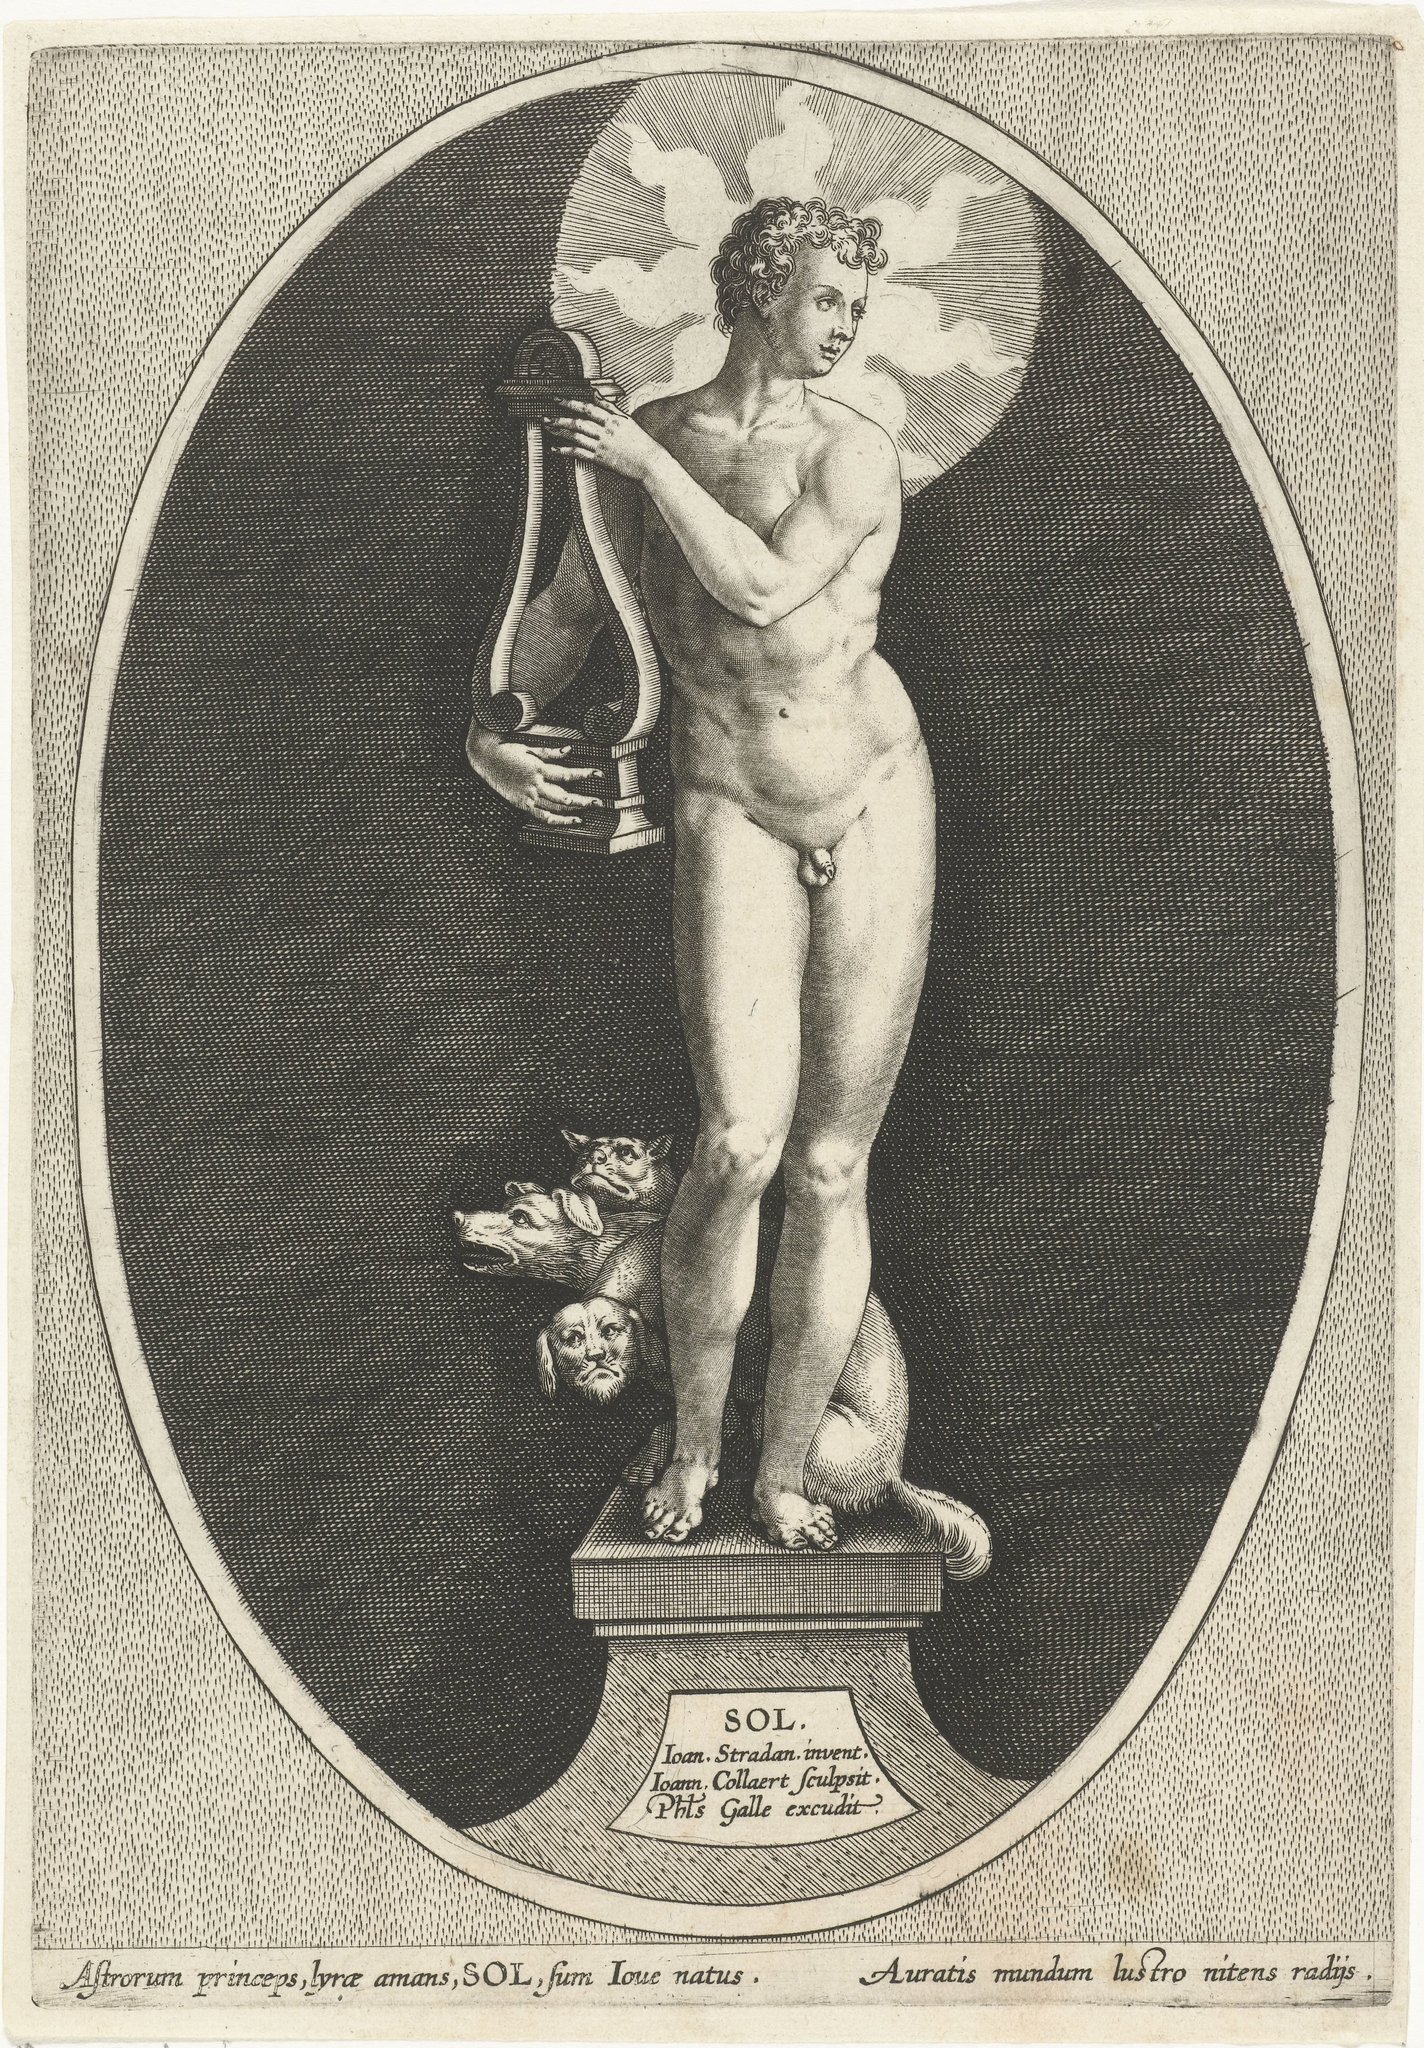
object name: print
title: Sol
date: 1585-1628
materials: paper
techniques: engraving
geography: florence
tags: apollo as sun-god, i.e. sol (helius), titan, sun as celestial body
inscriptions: collector's mark: Lugt 2228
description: Ovale lijst met centraal op een sokkel de naakte god Sol of Apollo. Hij heeft een lier in de hand. Naast hem zit de hellehond Cerebus. De prent heeft een Latijns onderschrift en maakt deel uit van een serie over de zeven planeten en hun goden.